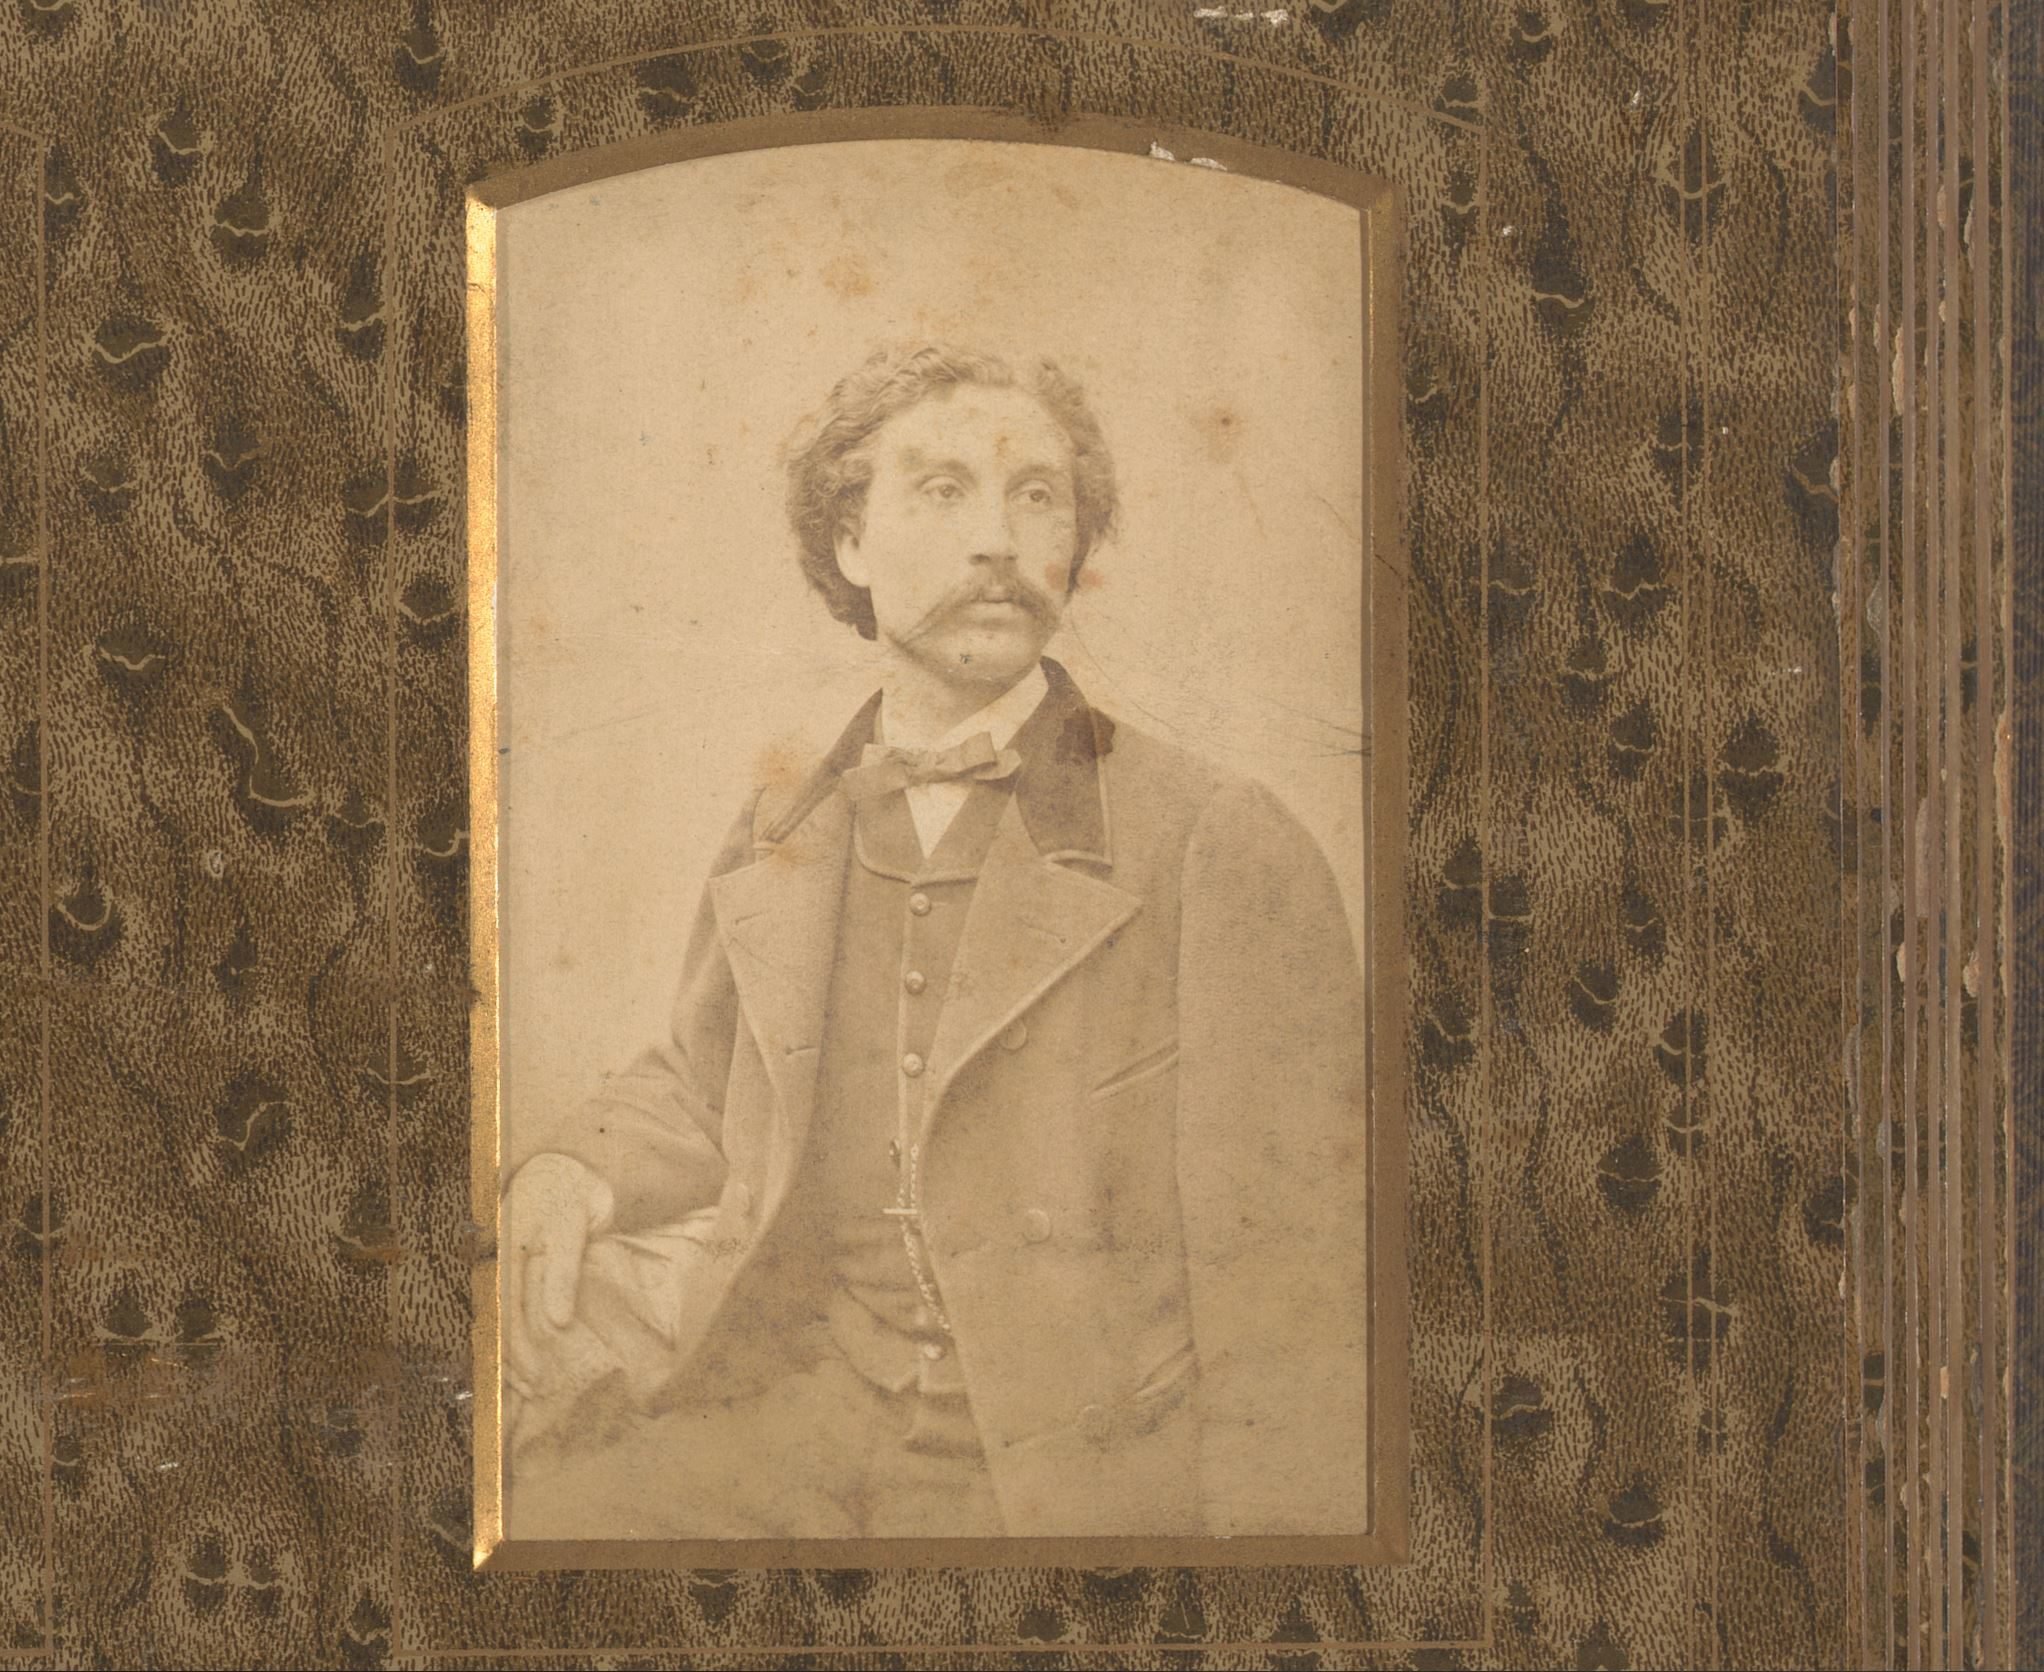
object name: photograph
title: Portret van een man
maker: Anonymous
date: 1850-1900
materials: cardboard, photographic support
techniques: albumen print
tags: historical persons